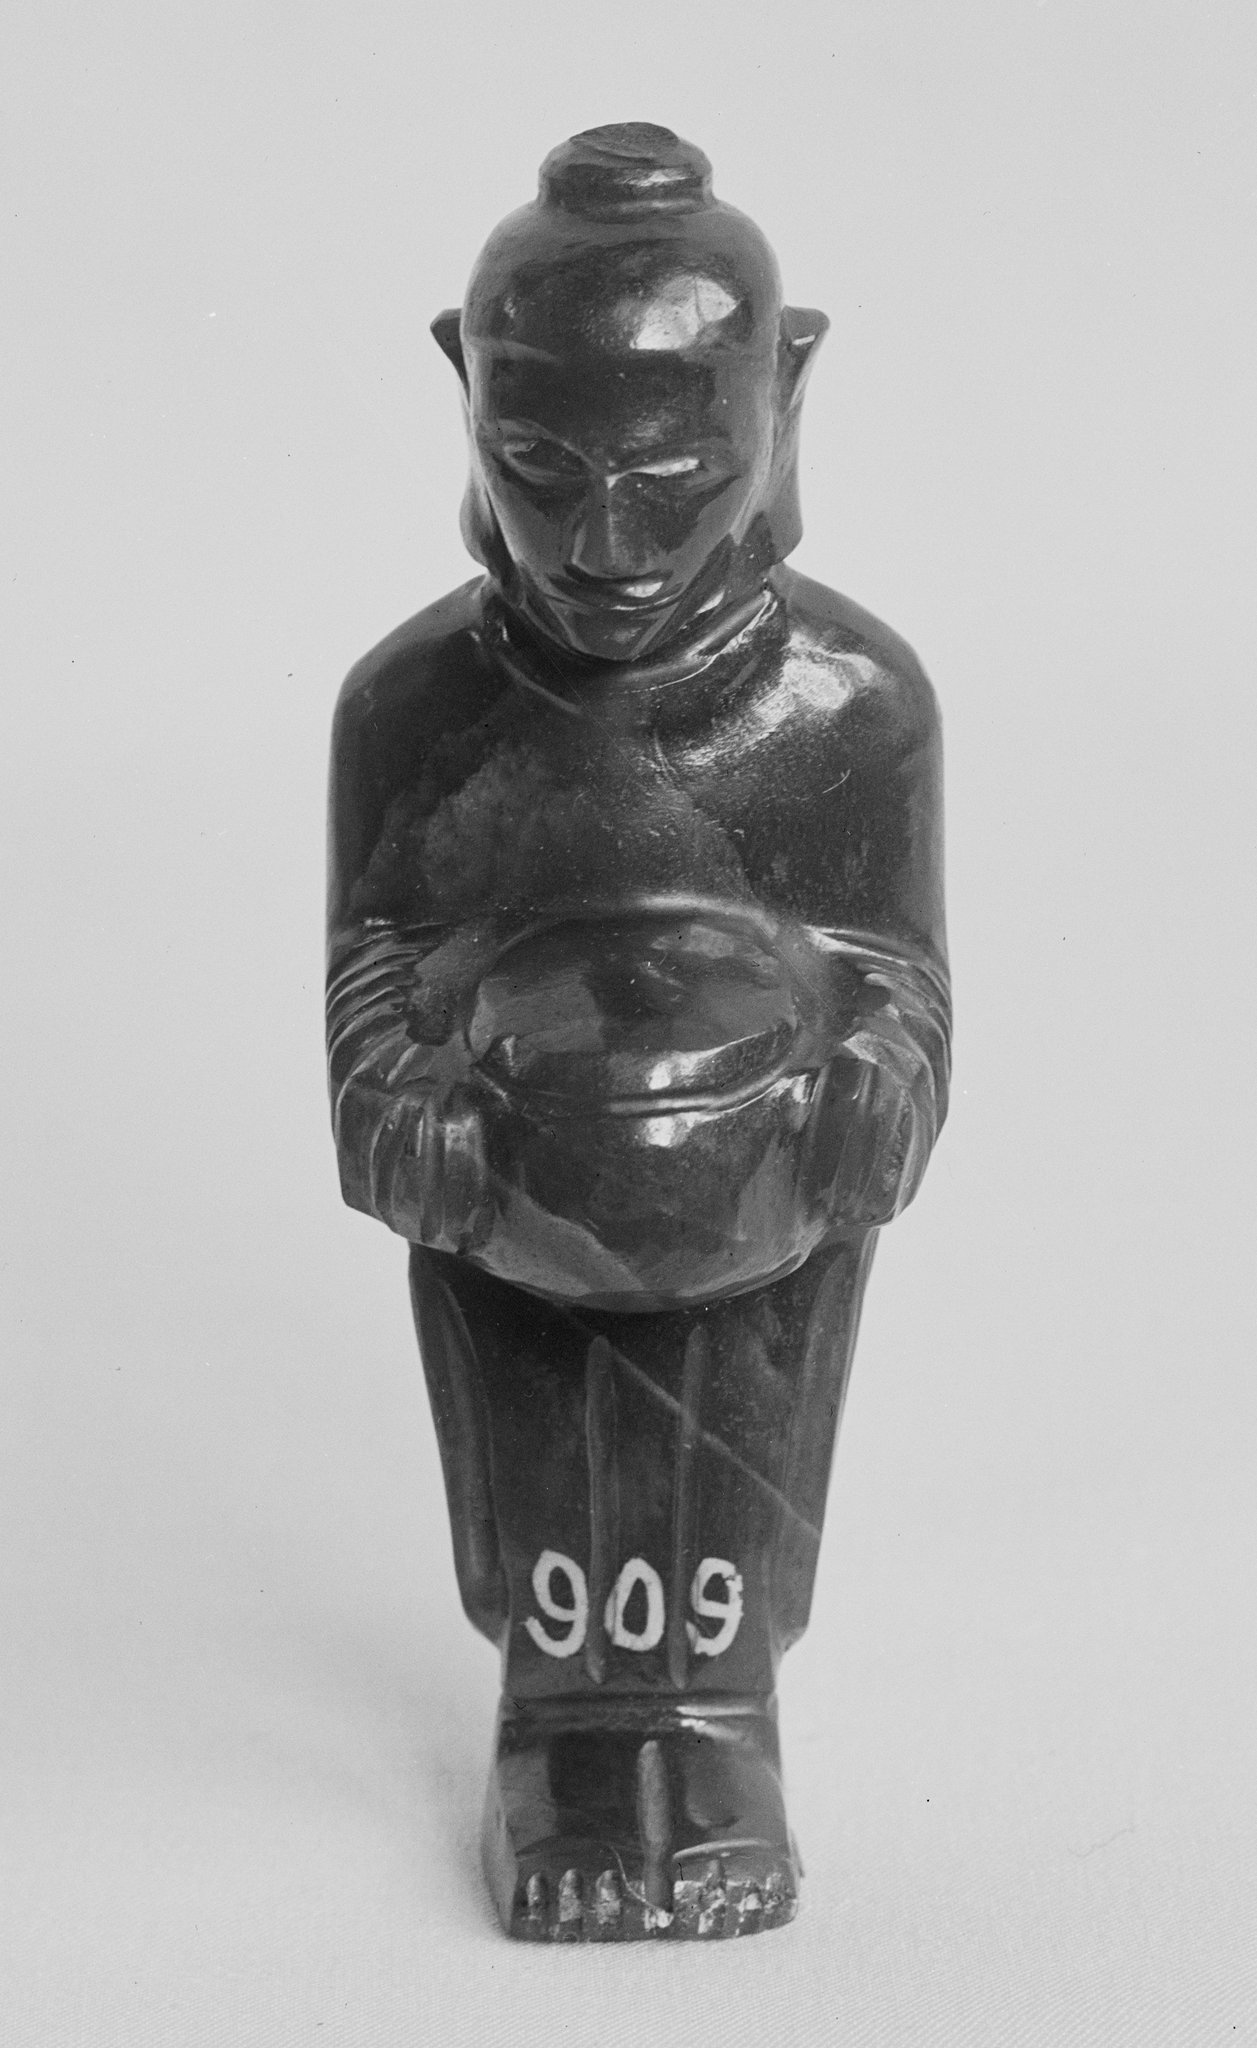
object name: figure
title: Figure of Buddhist Divinity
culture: chinese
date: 1701-1800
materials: stone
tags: men,buddhism